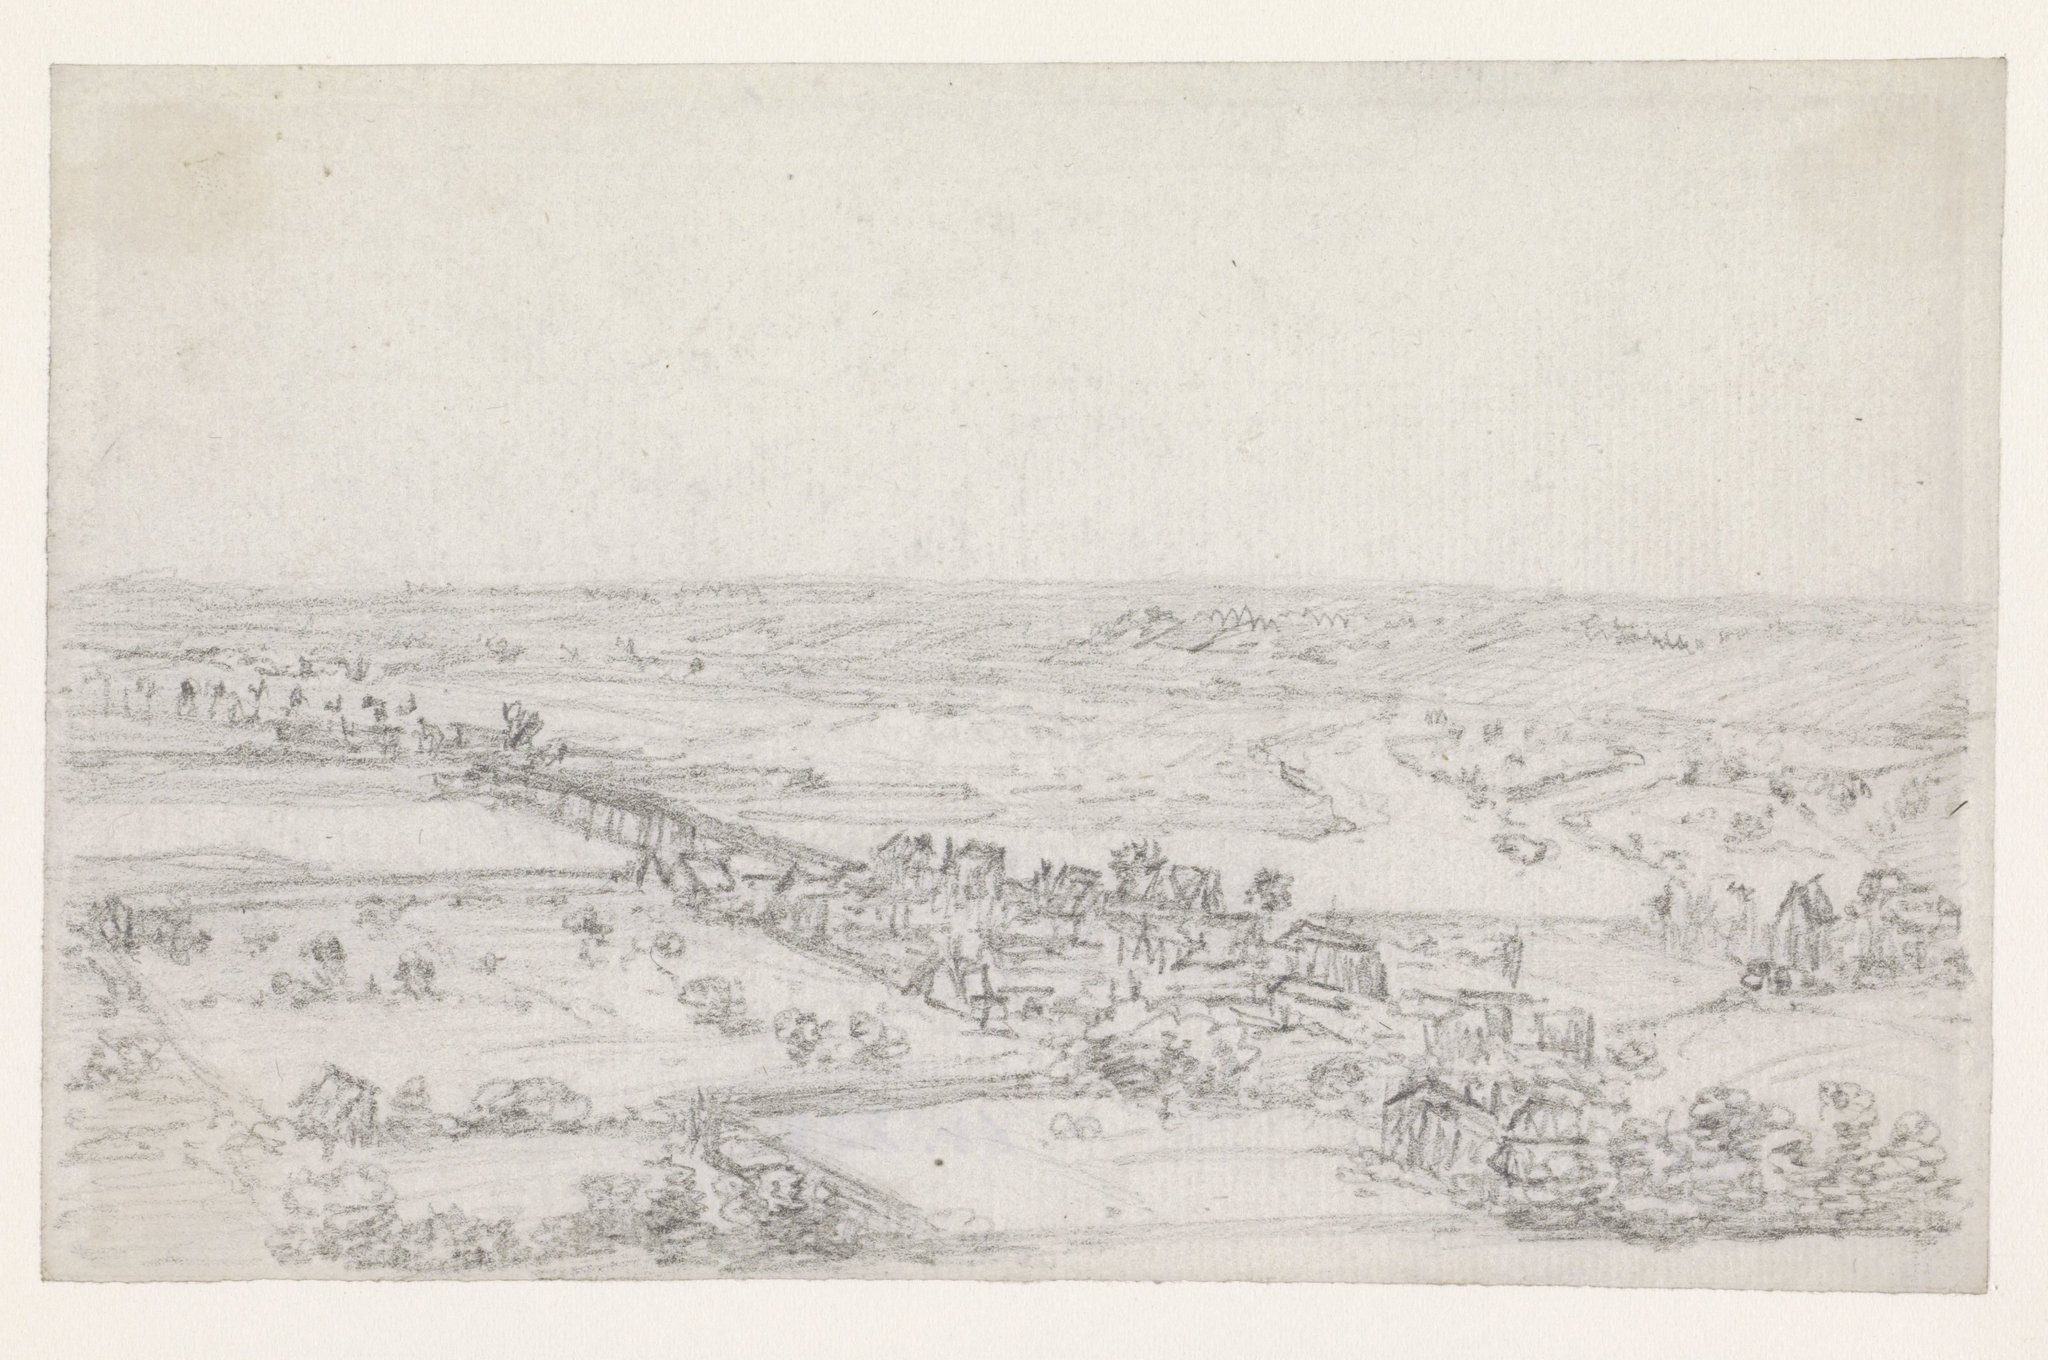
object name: drawing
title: Donker heuvelachtig landschap, rechts huizen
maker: georges michel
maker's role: draughtsman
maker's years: 1763-1843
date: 1773-1843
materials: chalk, paper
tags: landscapes in the temperate zone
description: Een van 120 tekeningen, afkomstig uit een 19e eeuws album met tekeningen van Georges Michel.